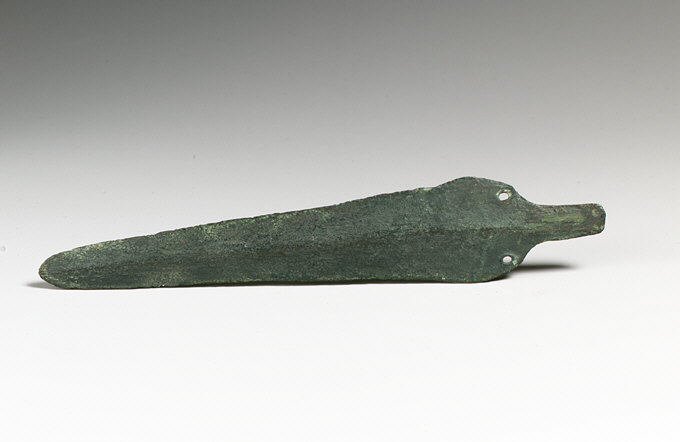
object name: dagger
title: Bronze dagger blade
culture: cypriot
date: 2500-1900 BCE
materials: bronze